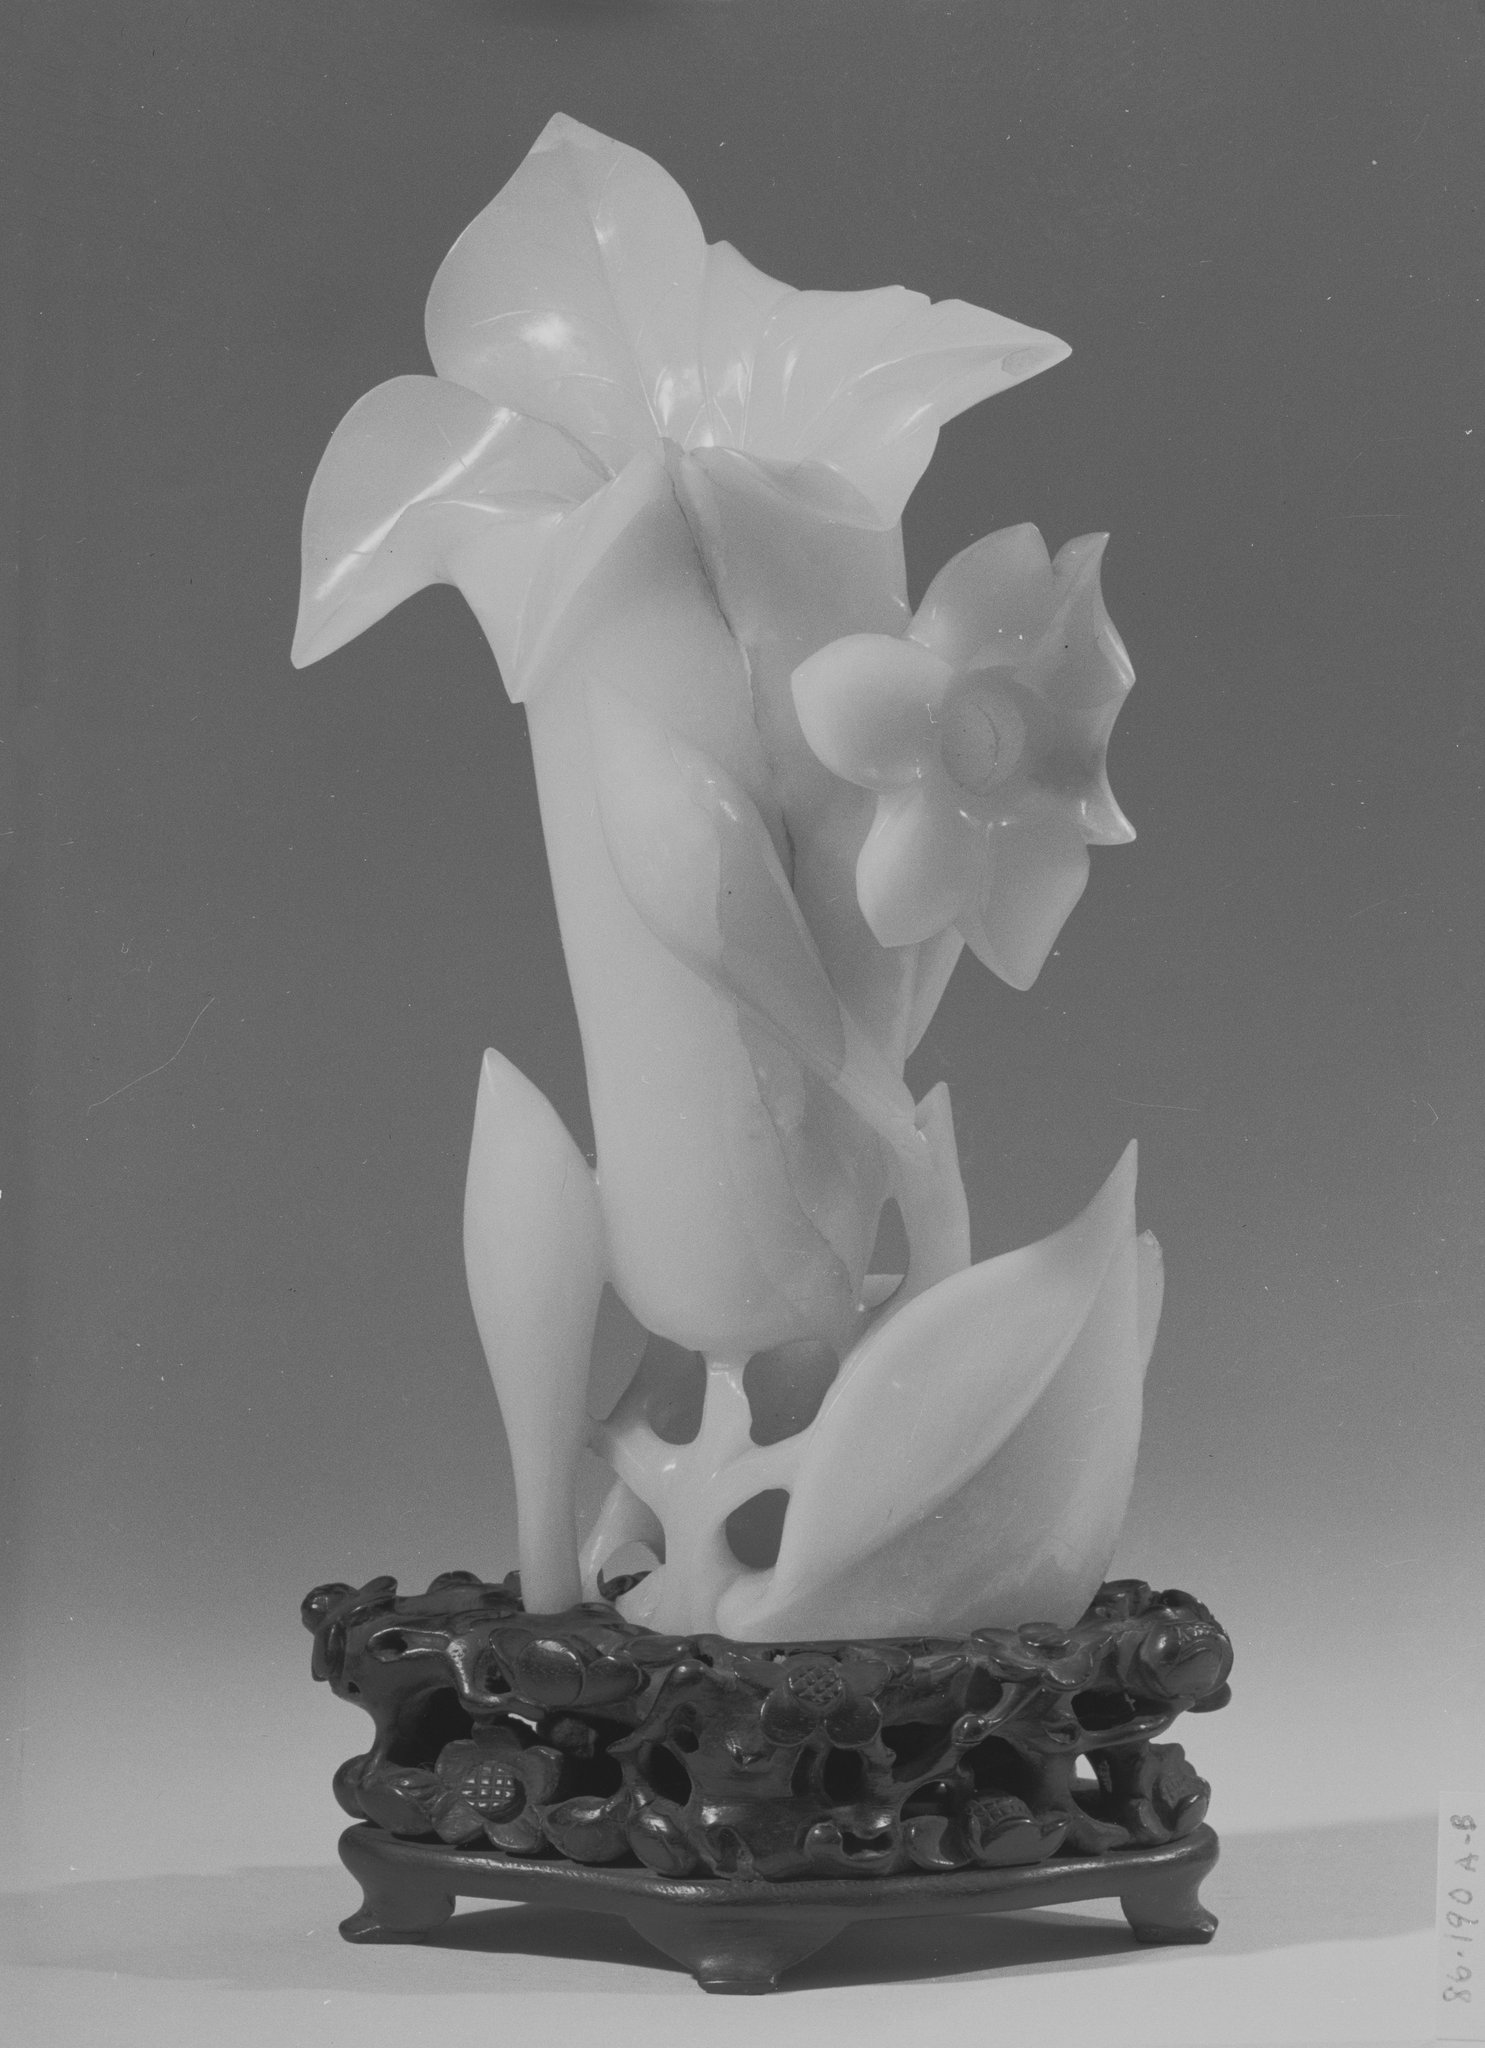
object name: vase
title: Vase in the shape of a magnolia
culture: chinese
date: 1701-1800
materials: jade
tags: flowers